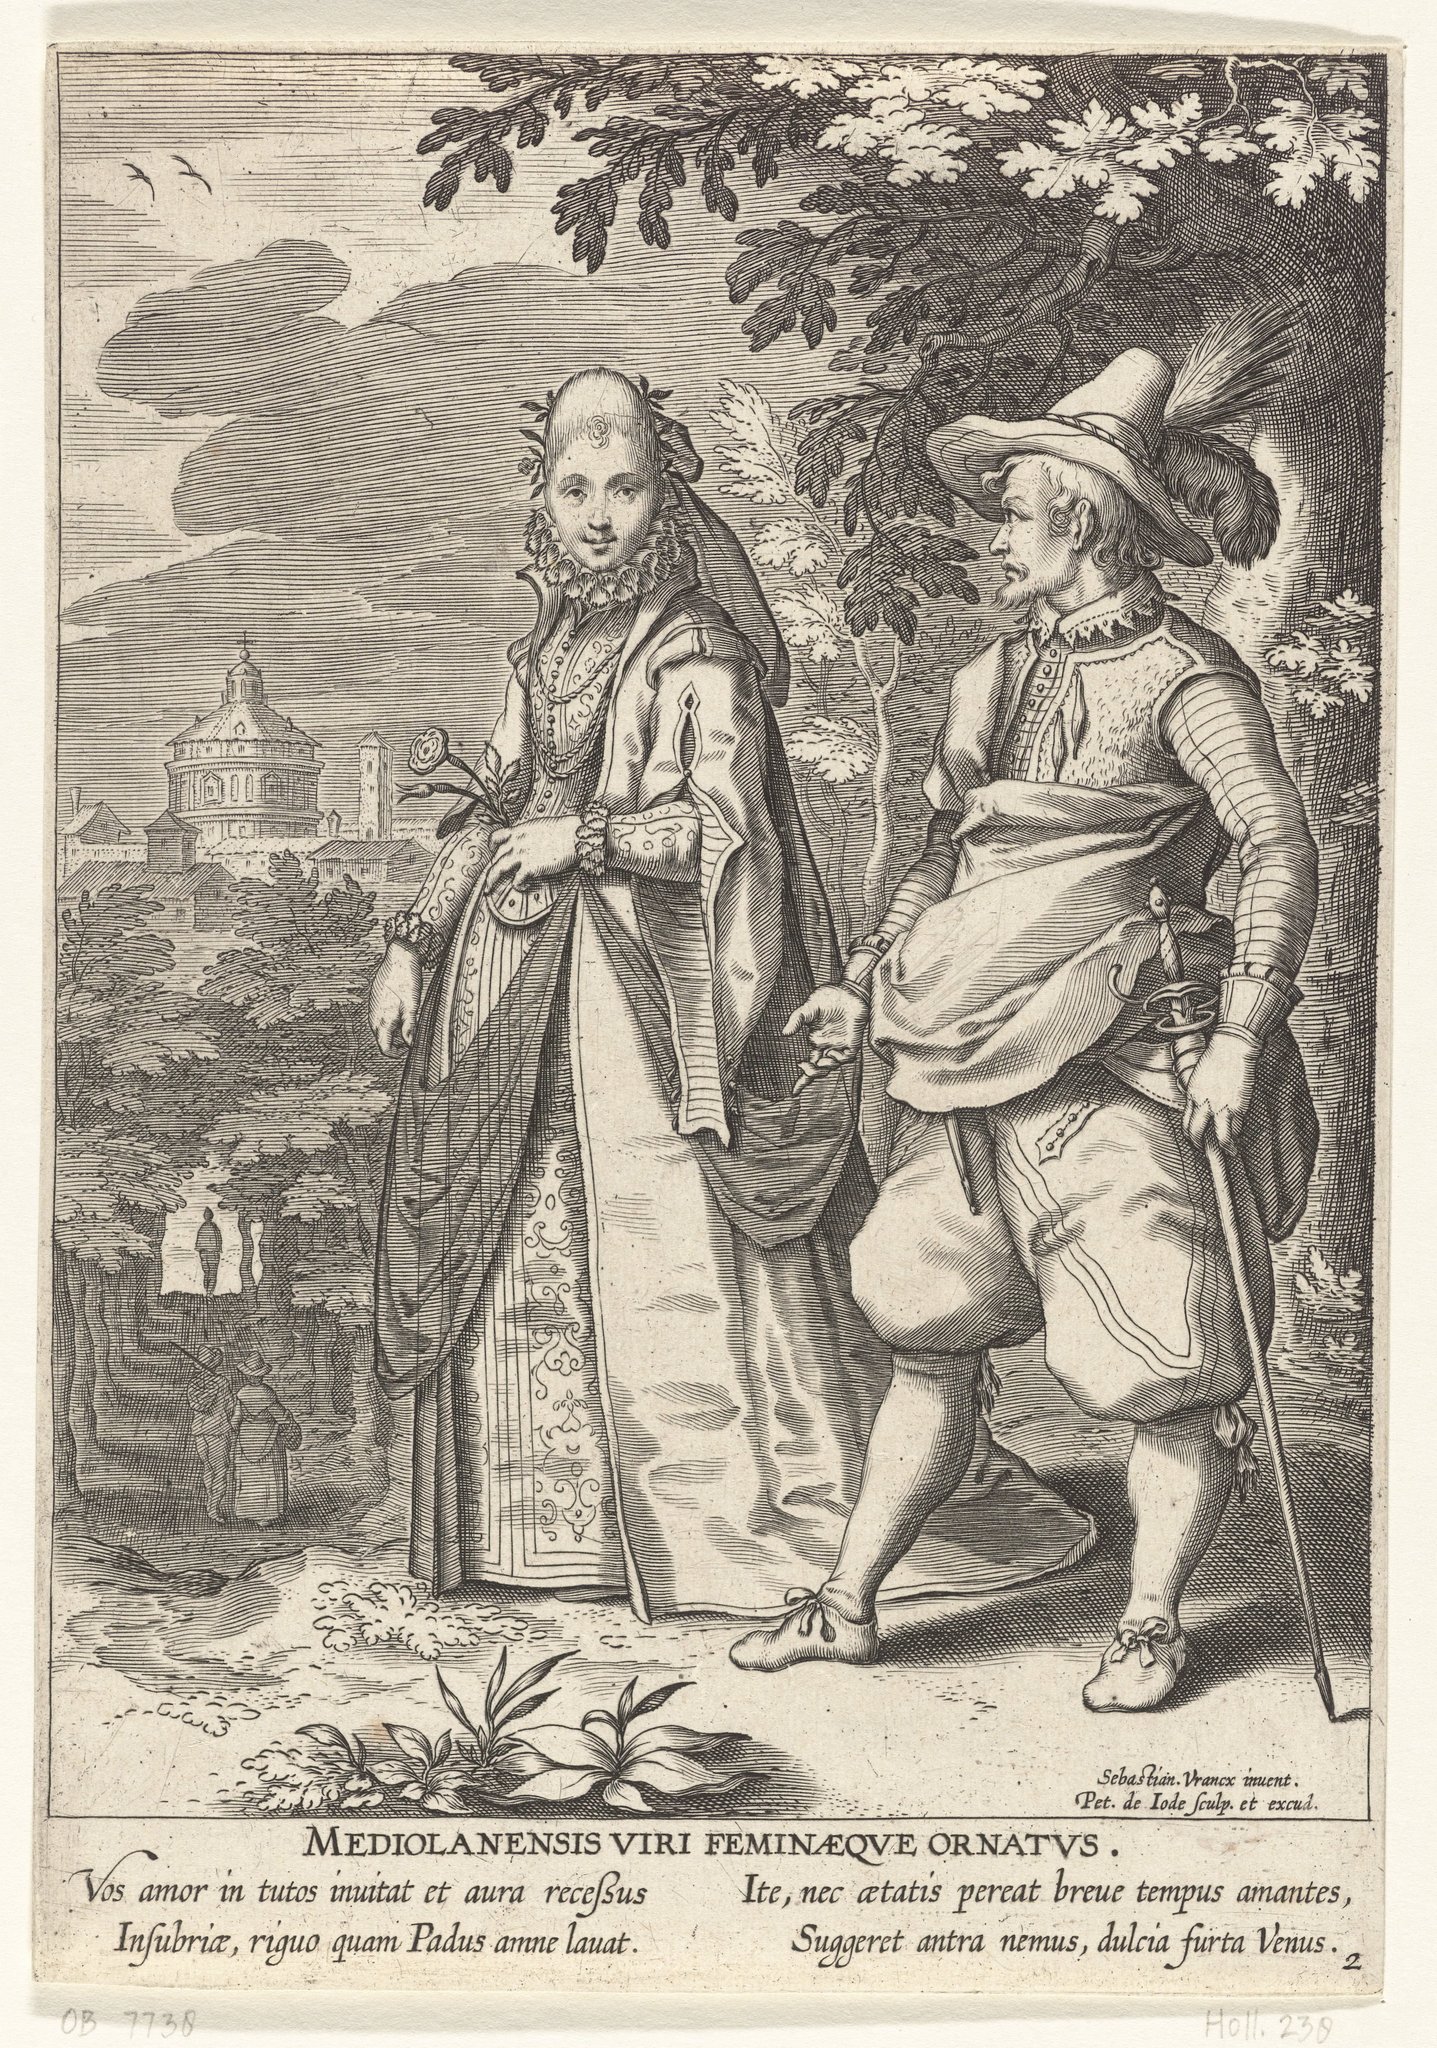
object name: costume print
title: Variarum Gentium Ornatus (Costumes of Different Nations)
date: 1605-1610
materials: paper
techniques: engraving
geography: antwerp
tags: veil (+ women's clothes), sleeves, coat (+ men's clothes), dress, gown (vlieger) (+ women's clothes), head-gear: hat (+ men's clothes), neck-gear: collar (+ women's clothes), clothes, costume (+ women's clothes), shoes, sandals (+ men's clothes), clothes, costume (+ men's clothes), folk costume, regional costume, neck-gear: collar (+ men's clothes), trousers, breeches, etc. (breeches) (+ men's clothes), clothing for the upper part of the body (doublet) (+ men's clothes), italy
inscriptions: caption: ‘Vos amor in tutos inuitat et aura recessus / Insubriae, riguo quam Padus amne lauat./ Ite, nec aetatis pereat breue tempus amantes,/ Suggeret antra nemus, dulcia furta Venus.’, title: ‘MEDIOLANENSIS VIRI FEMINAEQVE ORNATVS.’, collector's mark: Lugt 240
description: This series illustrates both the local scenery and the aristocratic fashions of Germany 1, France 2, Rome 3, Milan 4, the Netherlands 5 and Spain 6. Sometimes it is possible to spot famous monuments in the distance, such as Trajan’s Column in Rome. The inscriptions rarely refer to clothing, but plate 2 notes that the French constantly update their outfits – an oft-repeated stereotype of the period.